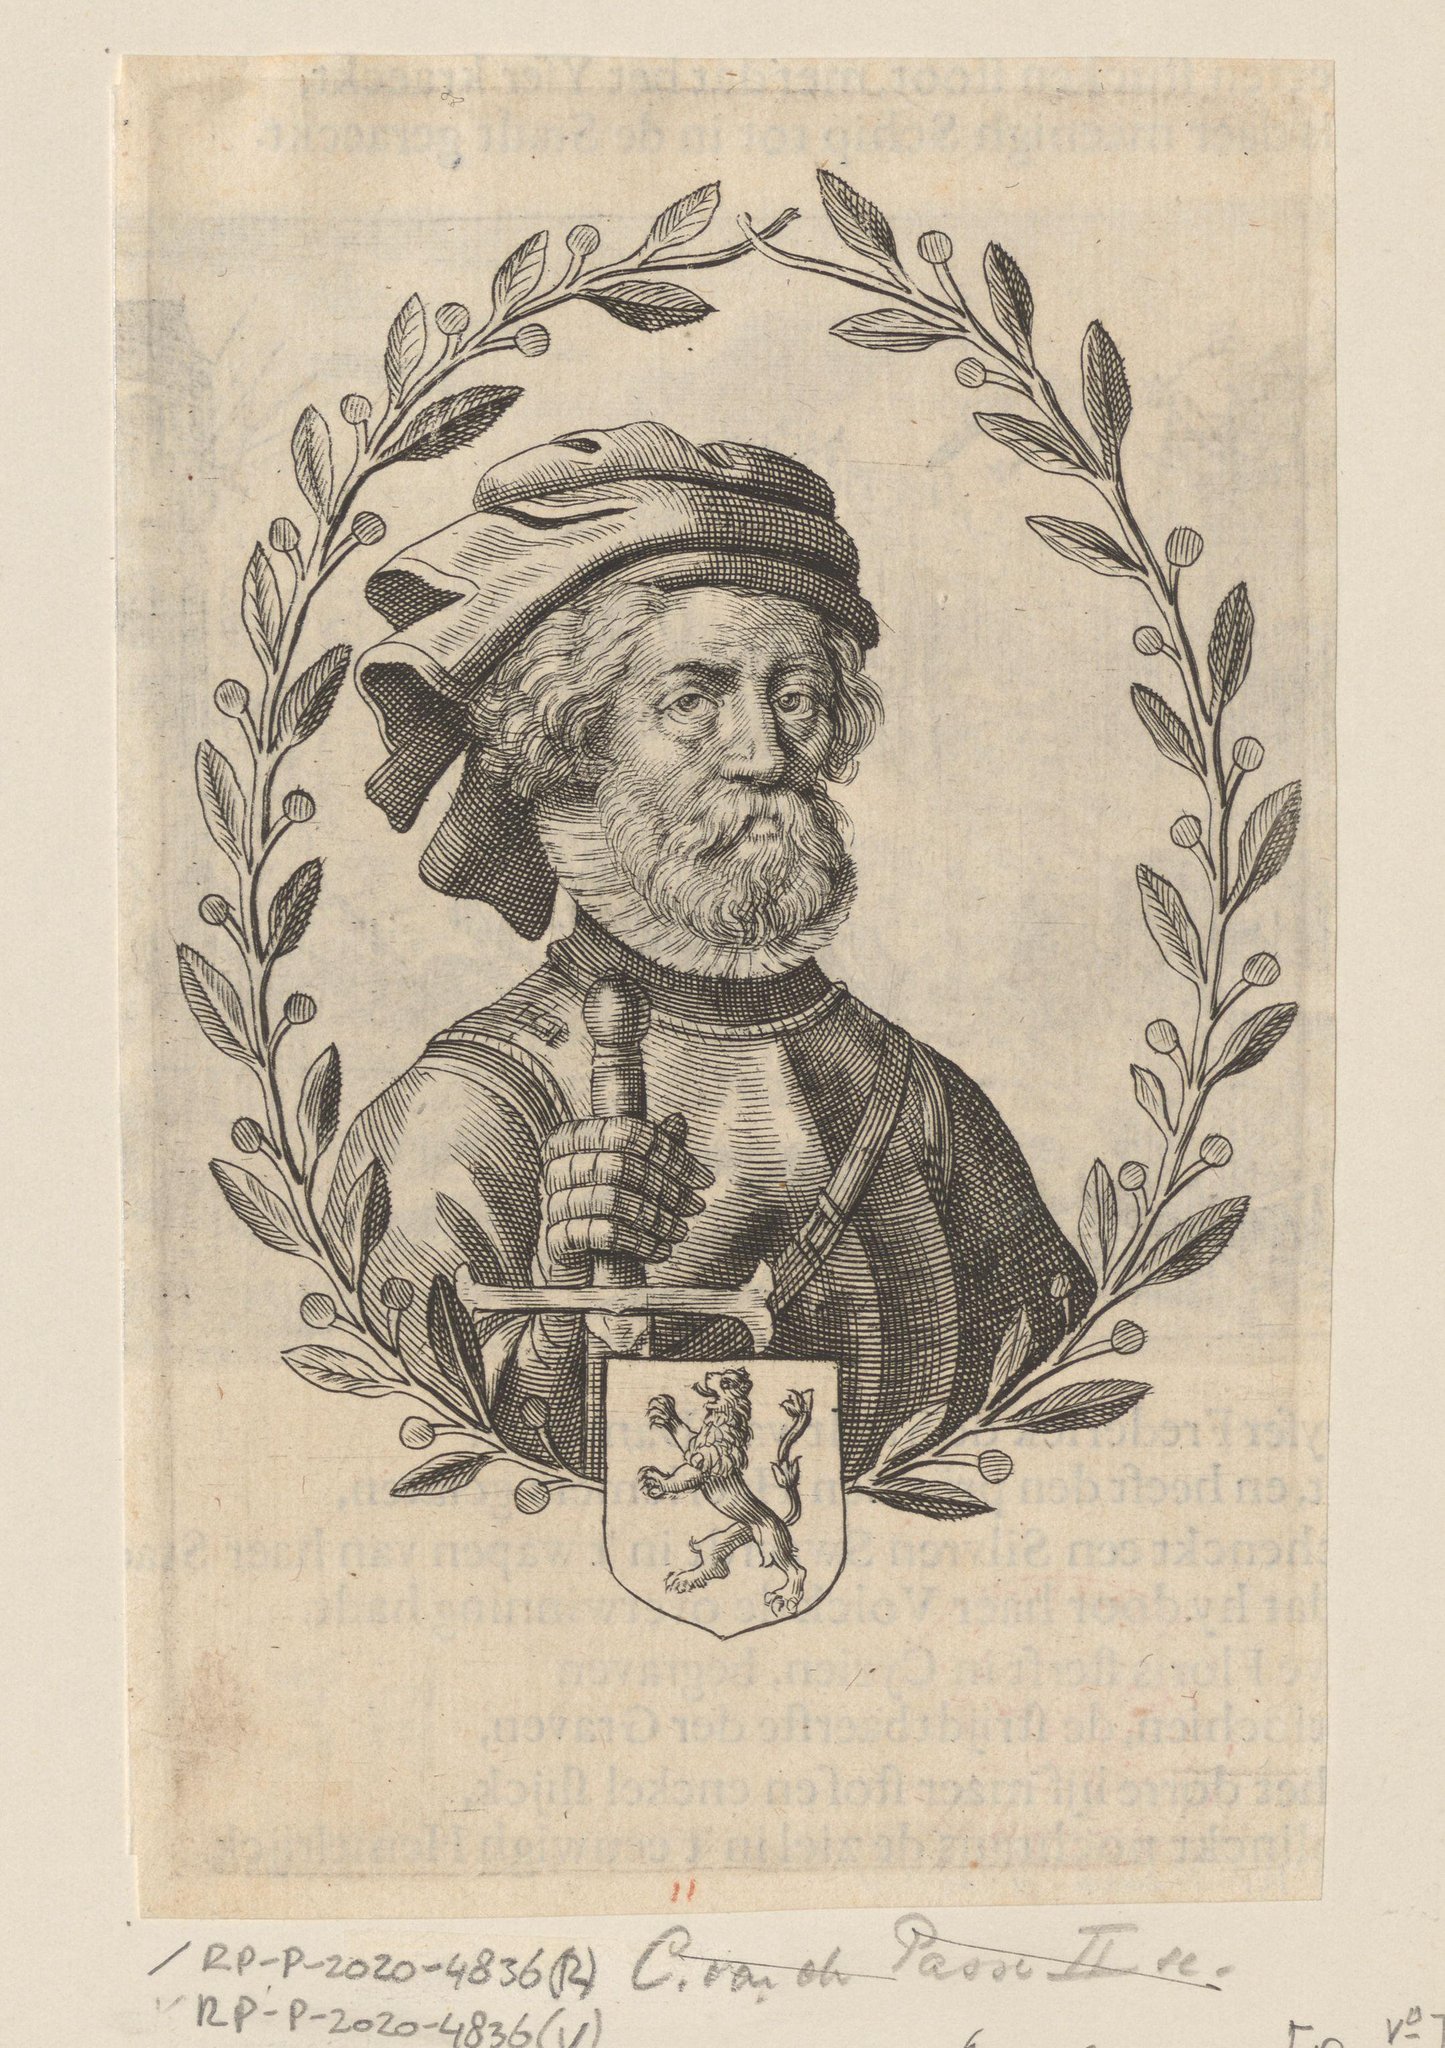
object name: book illustration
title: Portret van Dirk VII, graaf van Holland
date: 1645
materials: paper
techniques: engraving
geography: amsterdam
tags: historical persons, head-gear (with name), ruler, sovereign, armorial bearing, heraldry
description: Prent uit: Wachtendorp, Caspar. Oude Hollandsche geschiedenissen ofte, korte Hollandtsche rym-kronyck. 14 dln. Amsterdam: Johannes Pauli, 1645, dl. 1.